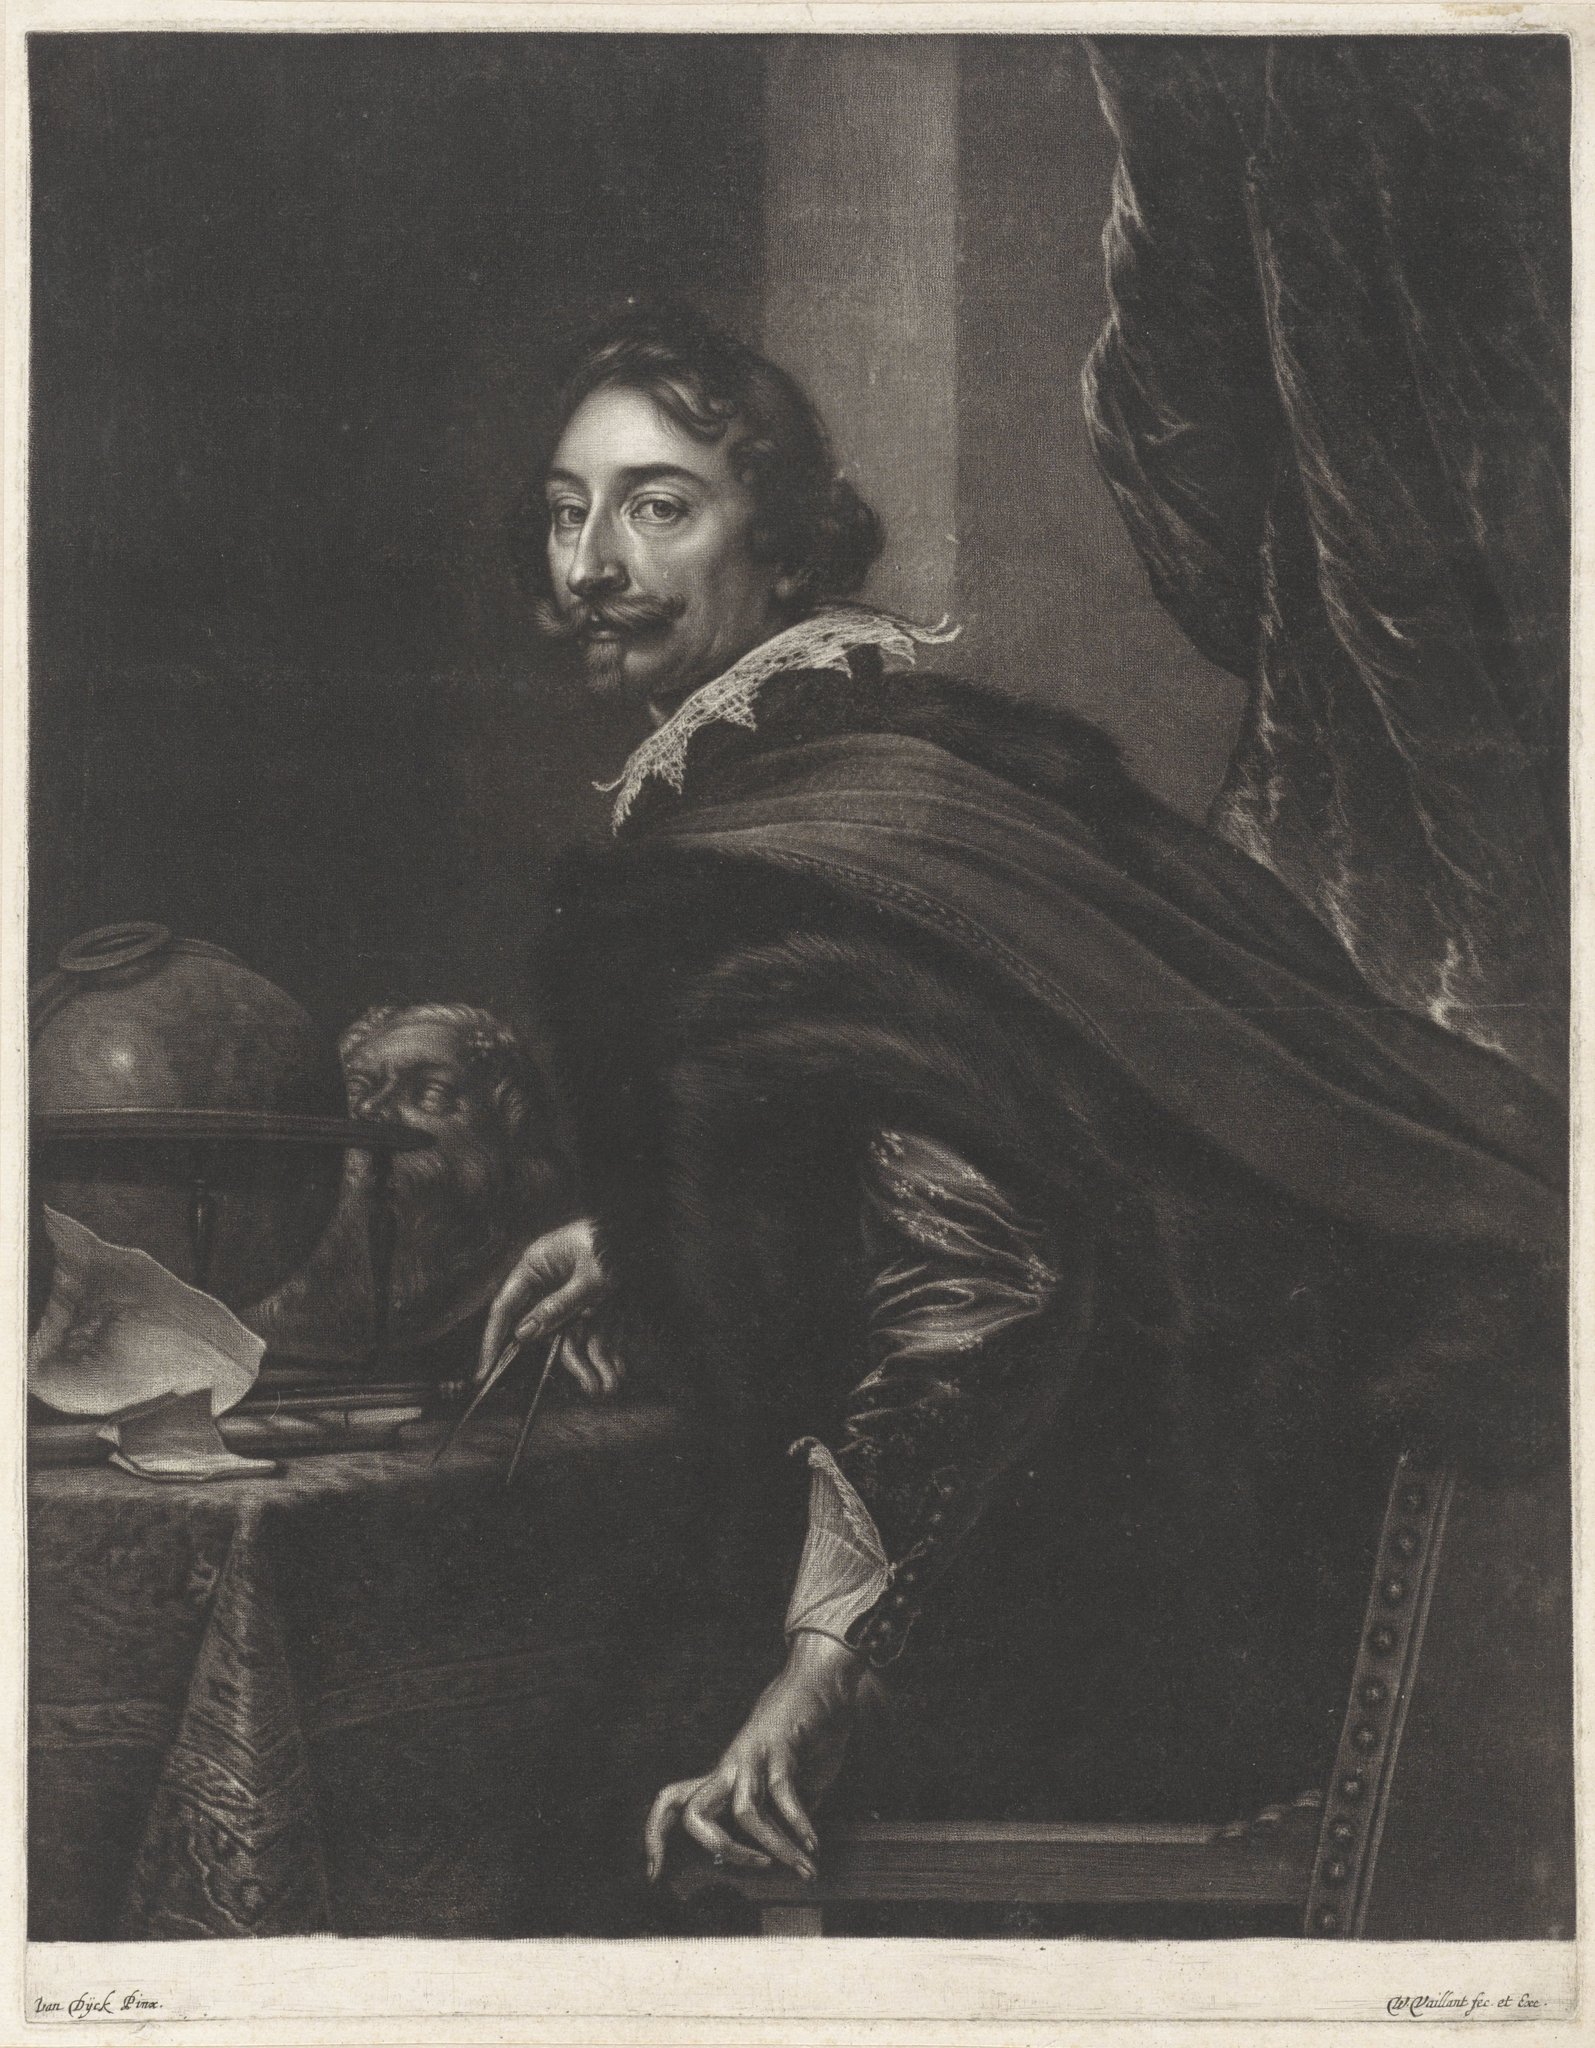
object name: print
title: Portret van Lucas van Uffel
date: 1658-1677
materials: paper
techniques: mezzotint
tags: lucas van uffel, compasses, piece of sculpture, reproduction of a piece of sculpture, globe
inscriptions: collector's mark: Lugt 10, collector's mark: Lugt 11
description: De koopman, reder en verzamelaar Lucas van Uffel staat op uit zijn stoel. In zijn hand een passer. Op de tafel liggen attributen die zijn brede interesse etaleert; een klassieke kop, een hemelbol, een tekening, een fluit en de strijkstok van een viola da gamba.